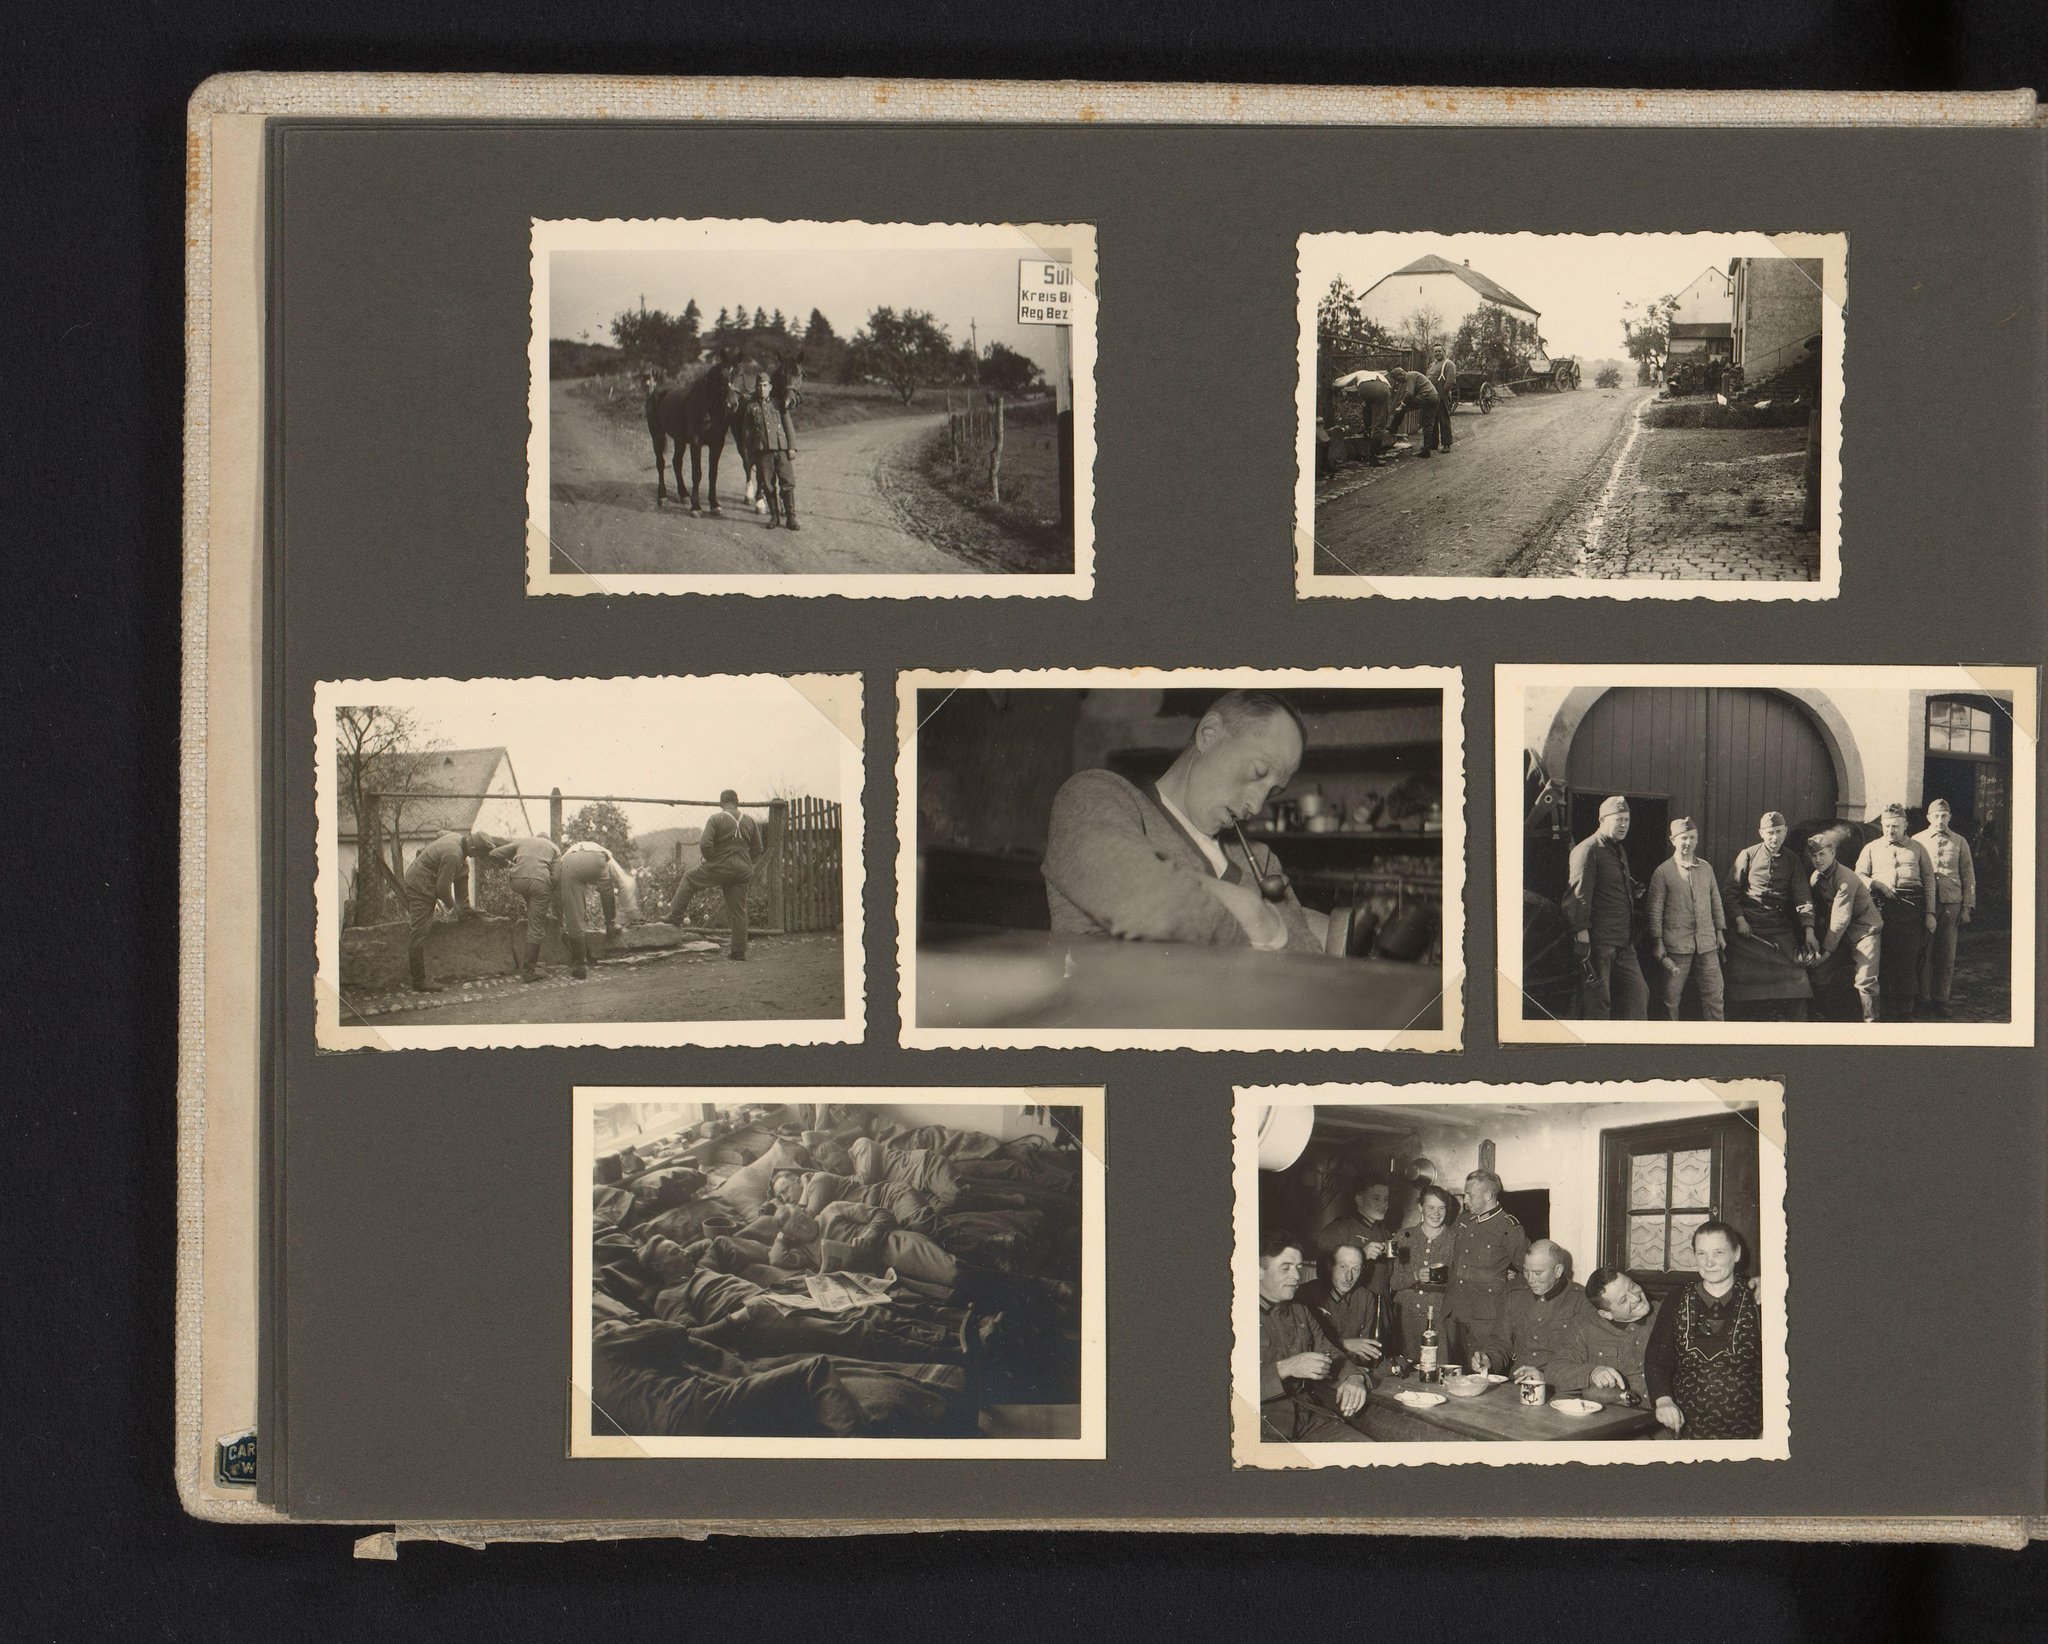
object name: photograph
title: Diverse onderwerpen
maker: Anonymous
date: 1910-1939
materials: cardboard, photographic support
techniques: gelatin silver print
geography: germany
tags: the company, the unit, the troop ~ military service, military training, recreation ~ the soldier off duty, germany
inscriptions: inscription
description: Albumblad met zeven foto's van militairen tijdens de opleiding, aan het werk, poserend voor een groepsfoto, in een slaapzaal en café, 1939. Onderdeel van de fotoalbum van de Wehrmacht 1938-1941.